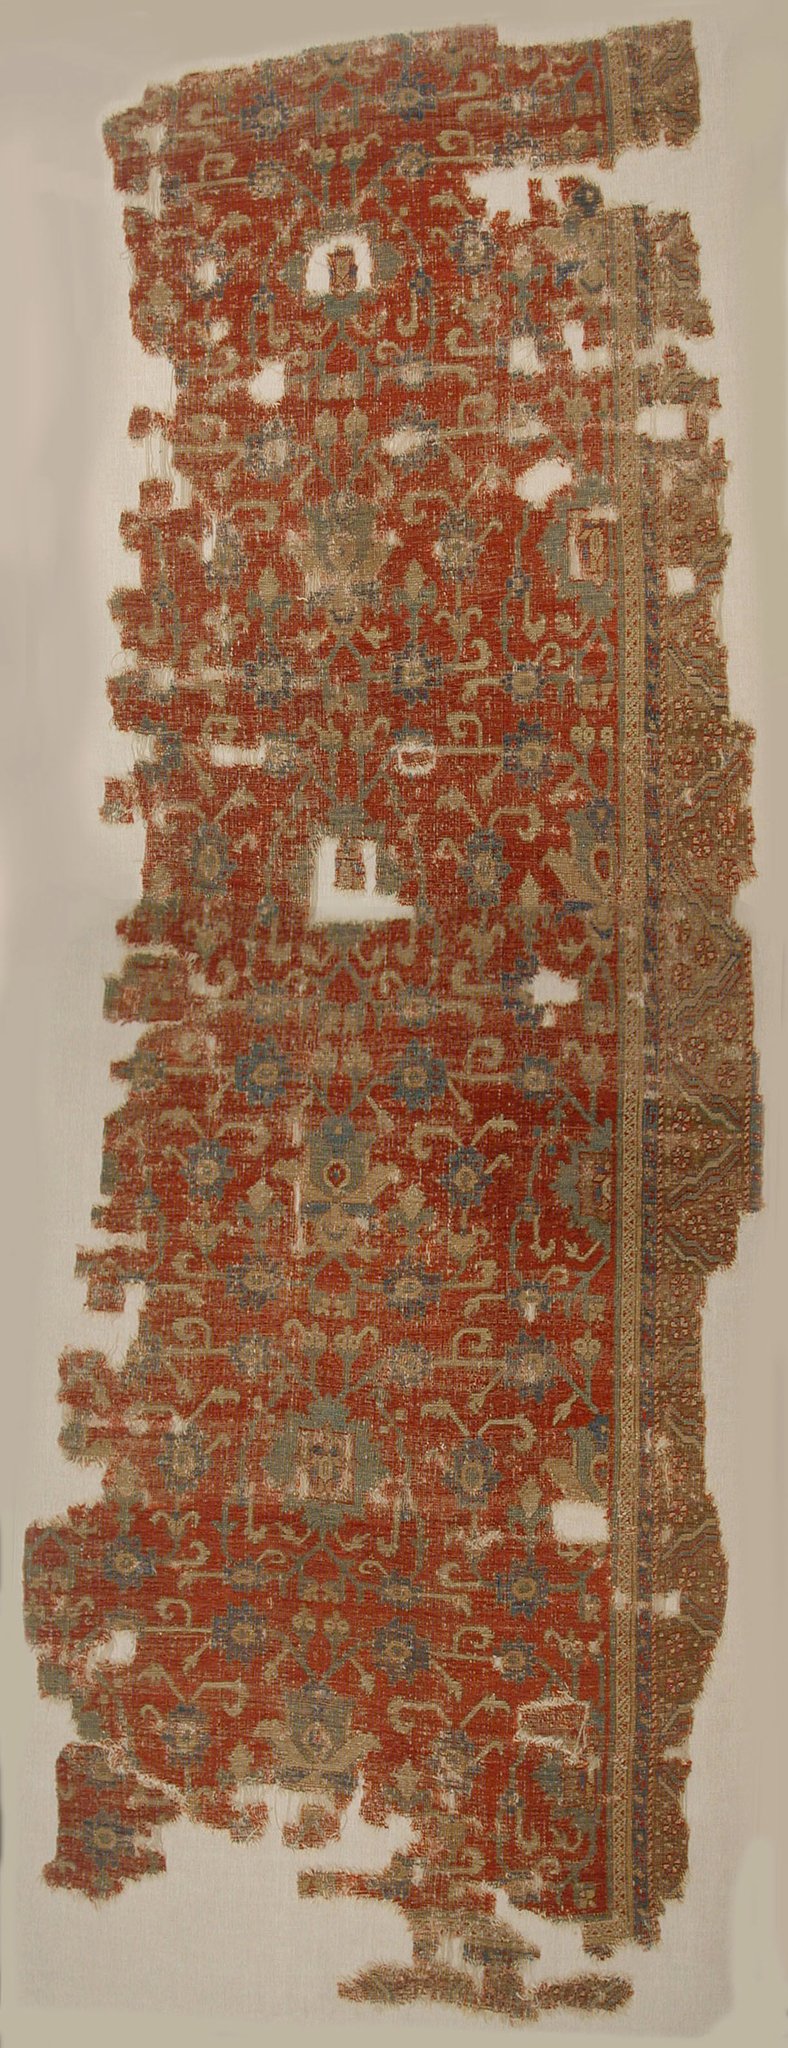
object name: carpet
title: Carpet with Chintimani Border and Lotus Design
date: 1601-1633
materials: hair, wool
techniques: asymmetrically knotted pile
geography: syria